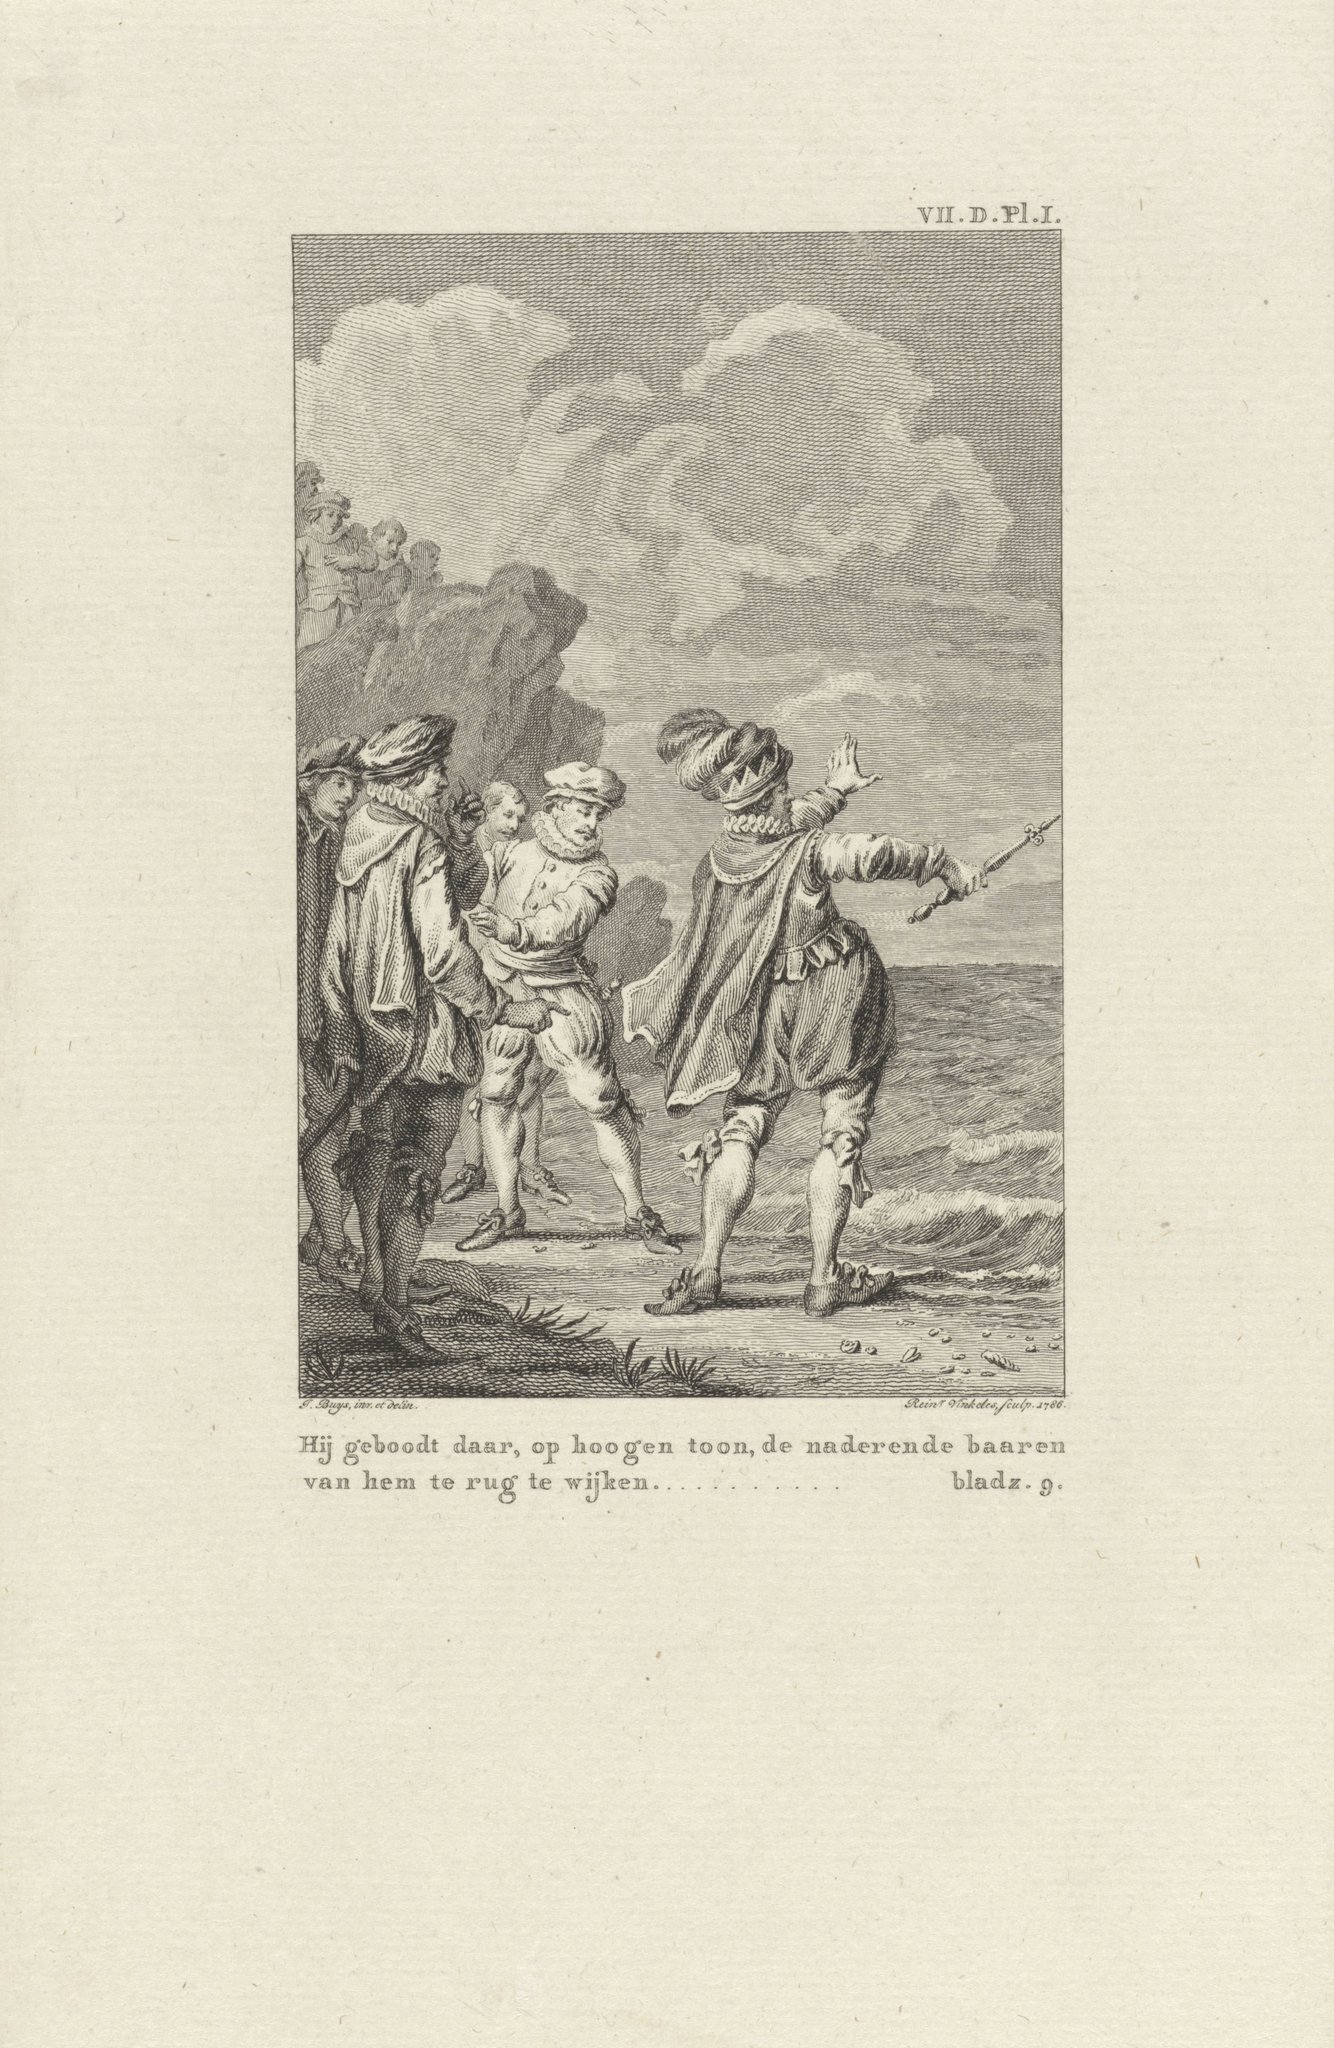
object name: book illustration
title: Hij geboodt daar, op hoogen toon (...)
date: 1786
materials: paper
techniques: engraving, etching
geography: amsterdam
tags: arm stretched forward - aa - both arms or hands, sceptre, staff (symbol of sovereignty), coast (+ landscape with figures, staffage)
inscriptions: collector's mark: Lugt 240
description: Knoet de Grote, koning van Engeland, Denemarken en Noorwegen, probeert tevergeefs de golven te laten wijken, om aan te tonen dat de elementen machtiger zijn dan hij. Rechtsboven: VII.D.Pl.I. Rechtsonder: Bladz.9.